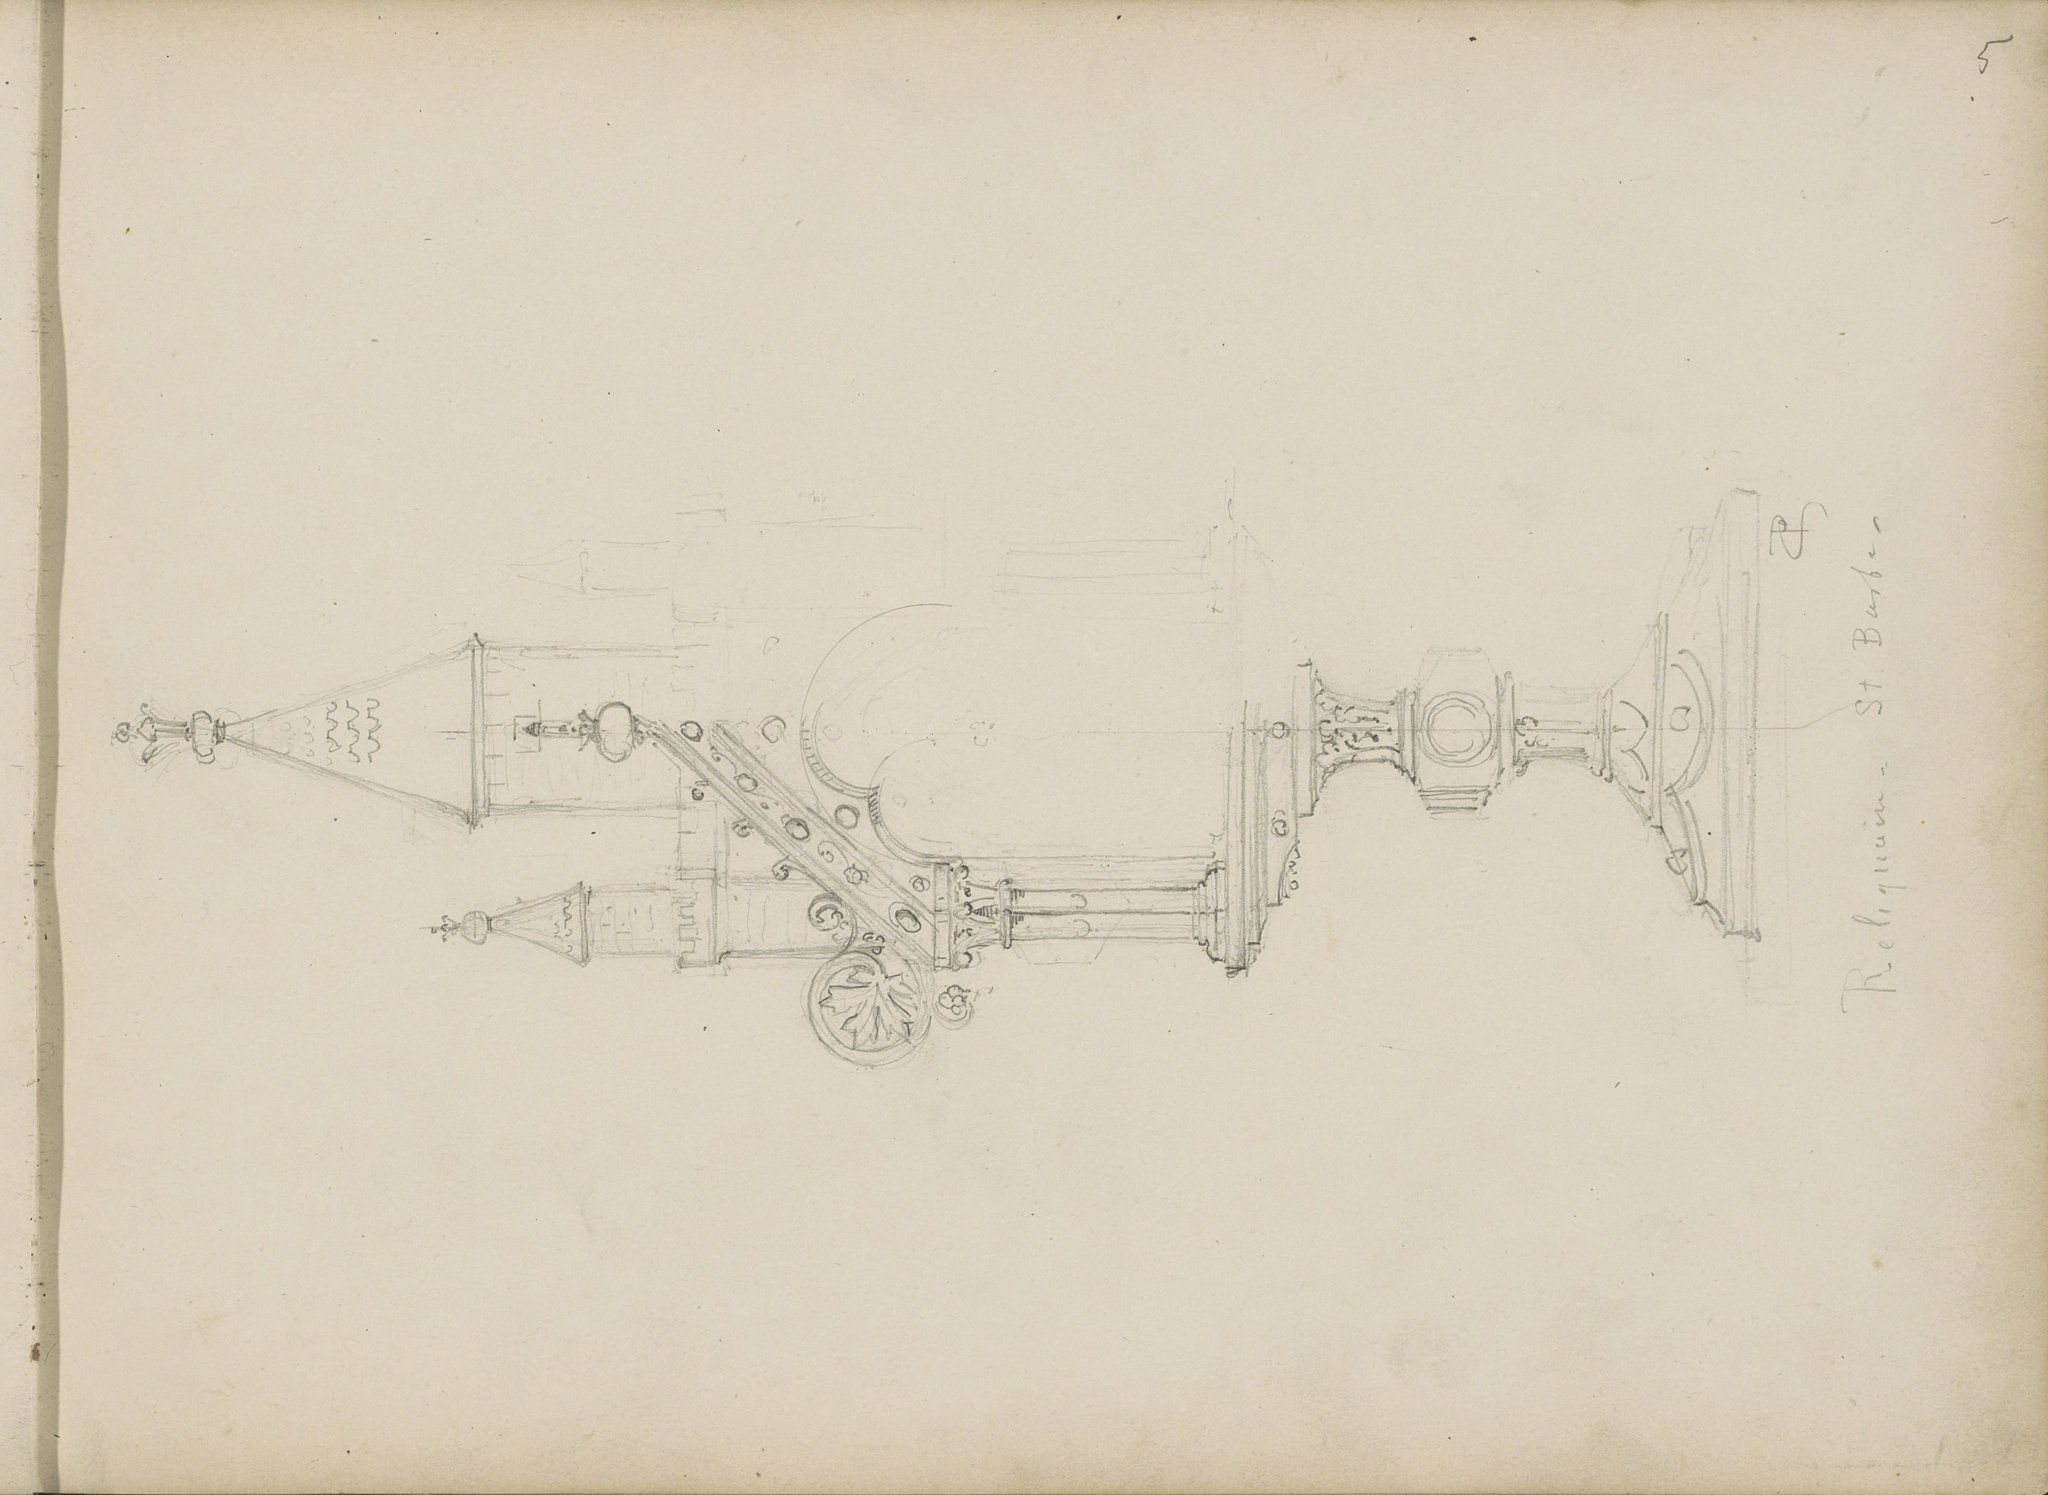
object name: sketchbook leaf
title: Reliekschrijn van de Heilige Barbara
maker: pierre joseph hubert cuypers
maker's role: draughtsman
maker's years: 1827-1921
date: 1857-1859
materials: paper, pencil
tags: relics (and reliquaries)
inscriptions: annotation: ‘Reliquaire St Barbe.’, monogram: ‘PC’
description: Blad 5 recto uit een schetsboek met 77 bladen.